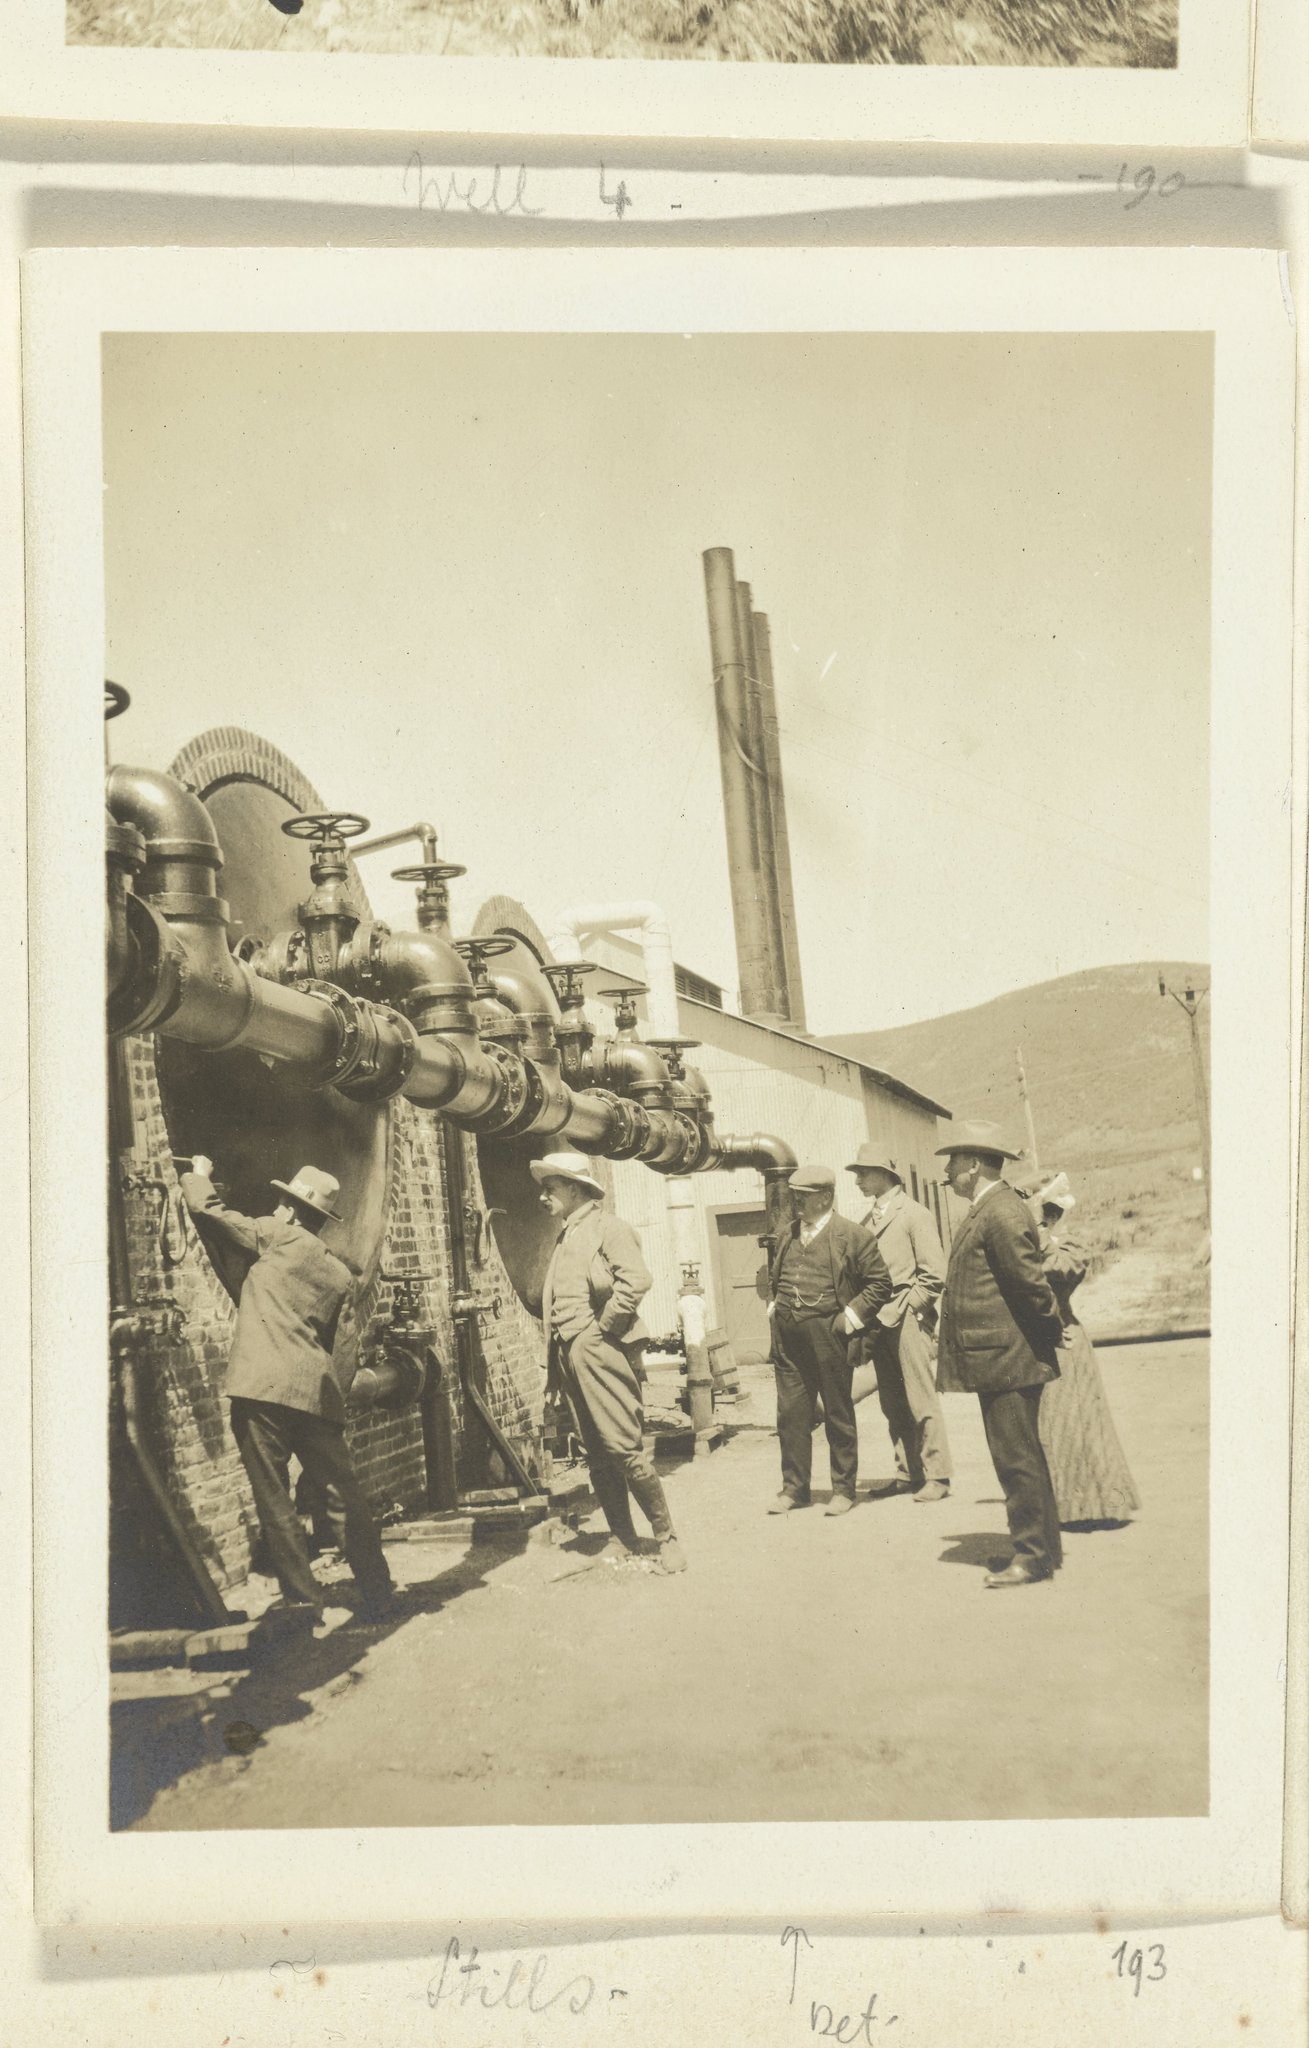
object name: photograph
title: Visit to an Oil Field in Purissima Hills, USA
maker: geldolph adriaan kessler (dolph)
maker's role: fotograaf, industrieel, voetballer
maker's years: 1884-1945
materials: cardboard, photographic support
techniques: gelatin silver print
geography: california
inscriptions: title: ‘Stills’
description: In 1908 Kessler accompanied the director of Koninklijke Olie (Royal Dutch Petroleum Company, later Shell), Henri Deterding, as secretary on a world tour. He travelled to Canada and the United States via the Dutch East Indies, Singapore, China, and Japan. Dolph’s photo album contains pictures of an oil field in California, as well as San Francisco’s town hall which had collapsed during an earthquake.